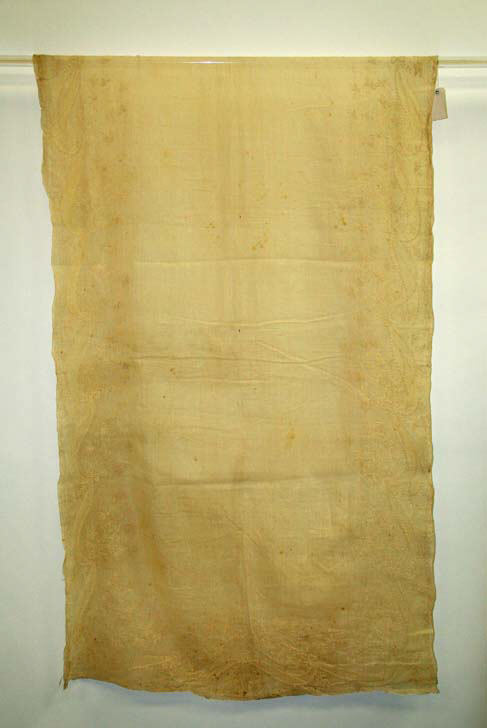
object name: scarf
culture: american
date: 1830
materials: cotton